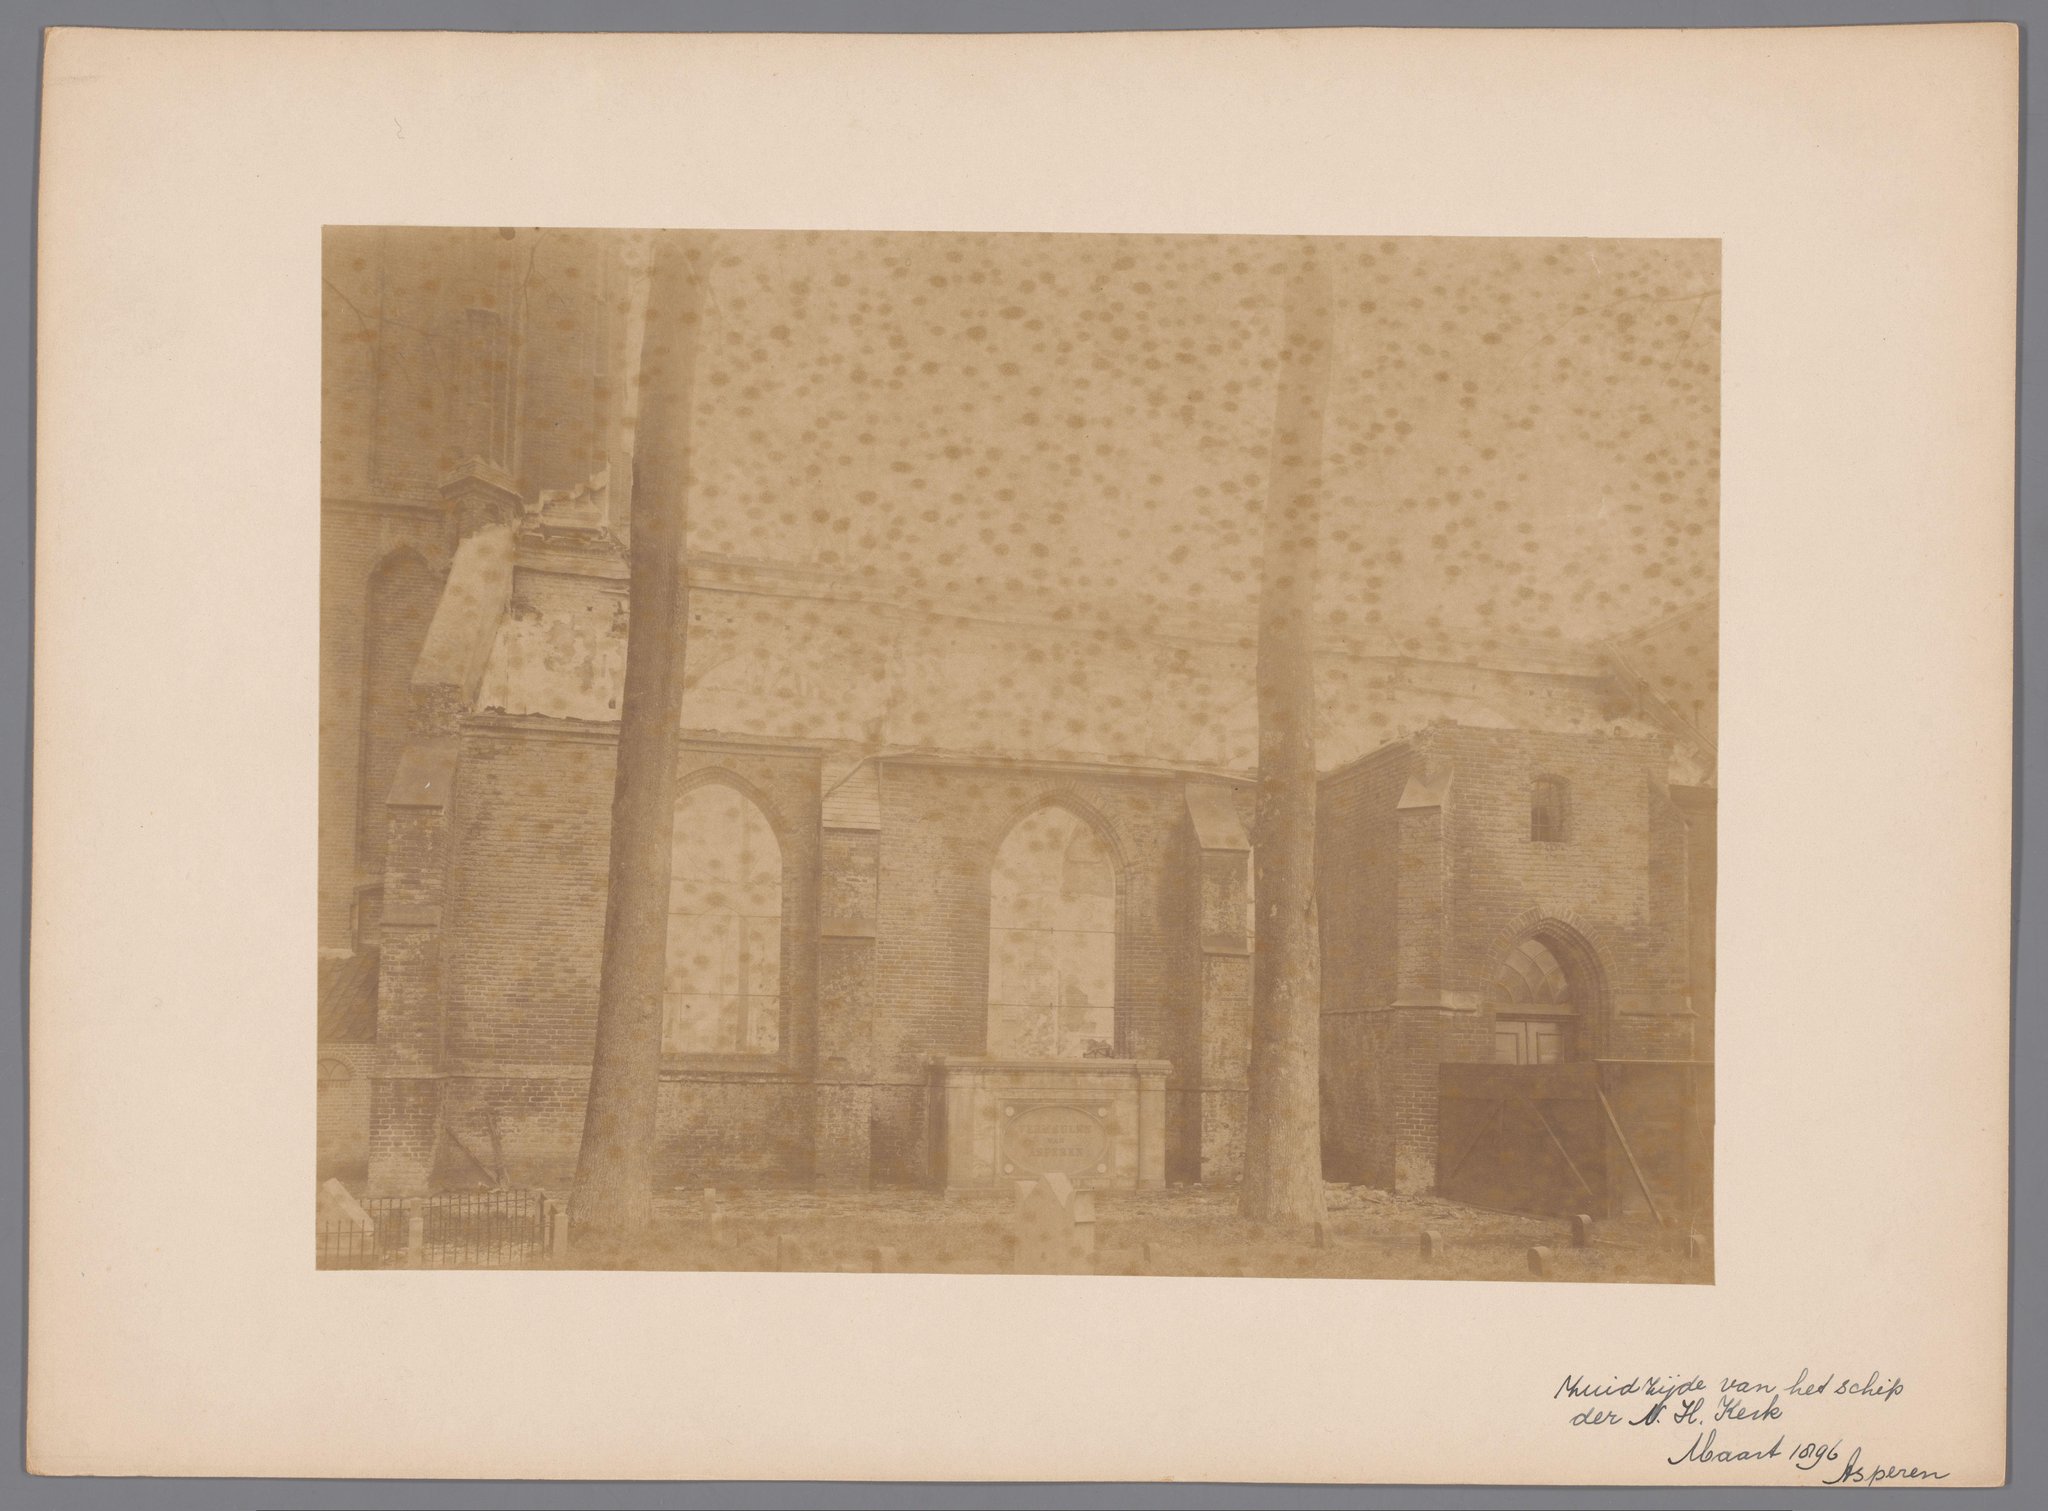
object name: photograph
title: Zuidzijde van de Nederlands-hervormde kerk te Asperen na de brand van 1896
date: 1896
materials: cardboard, photographic support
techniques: albumen print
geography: asperen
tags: church (exterior)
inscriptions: annotation: ‘Zuidzijde van het schip der N.H. Kerk/ Maart 1896 Asperen’, annotation: ‘Asperen (Z.H.)/ Zuidzijde v/h schip den kerk/ maart 1896’